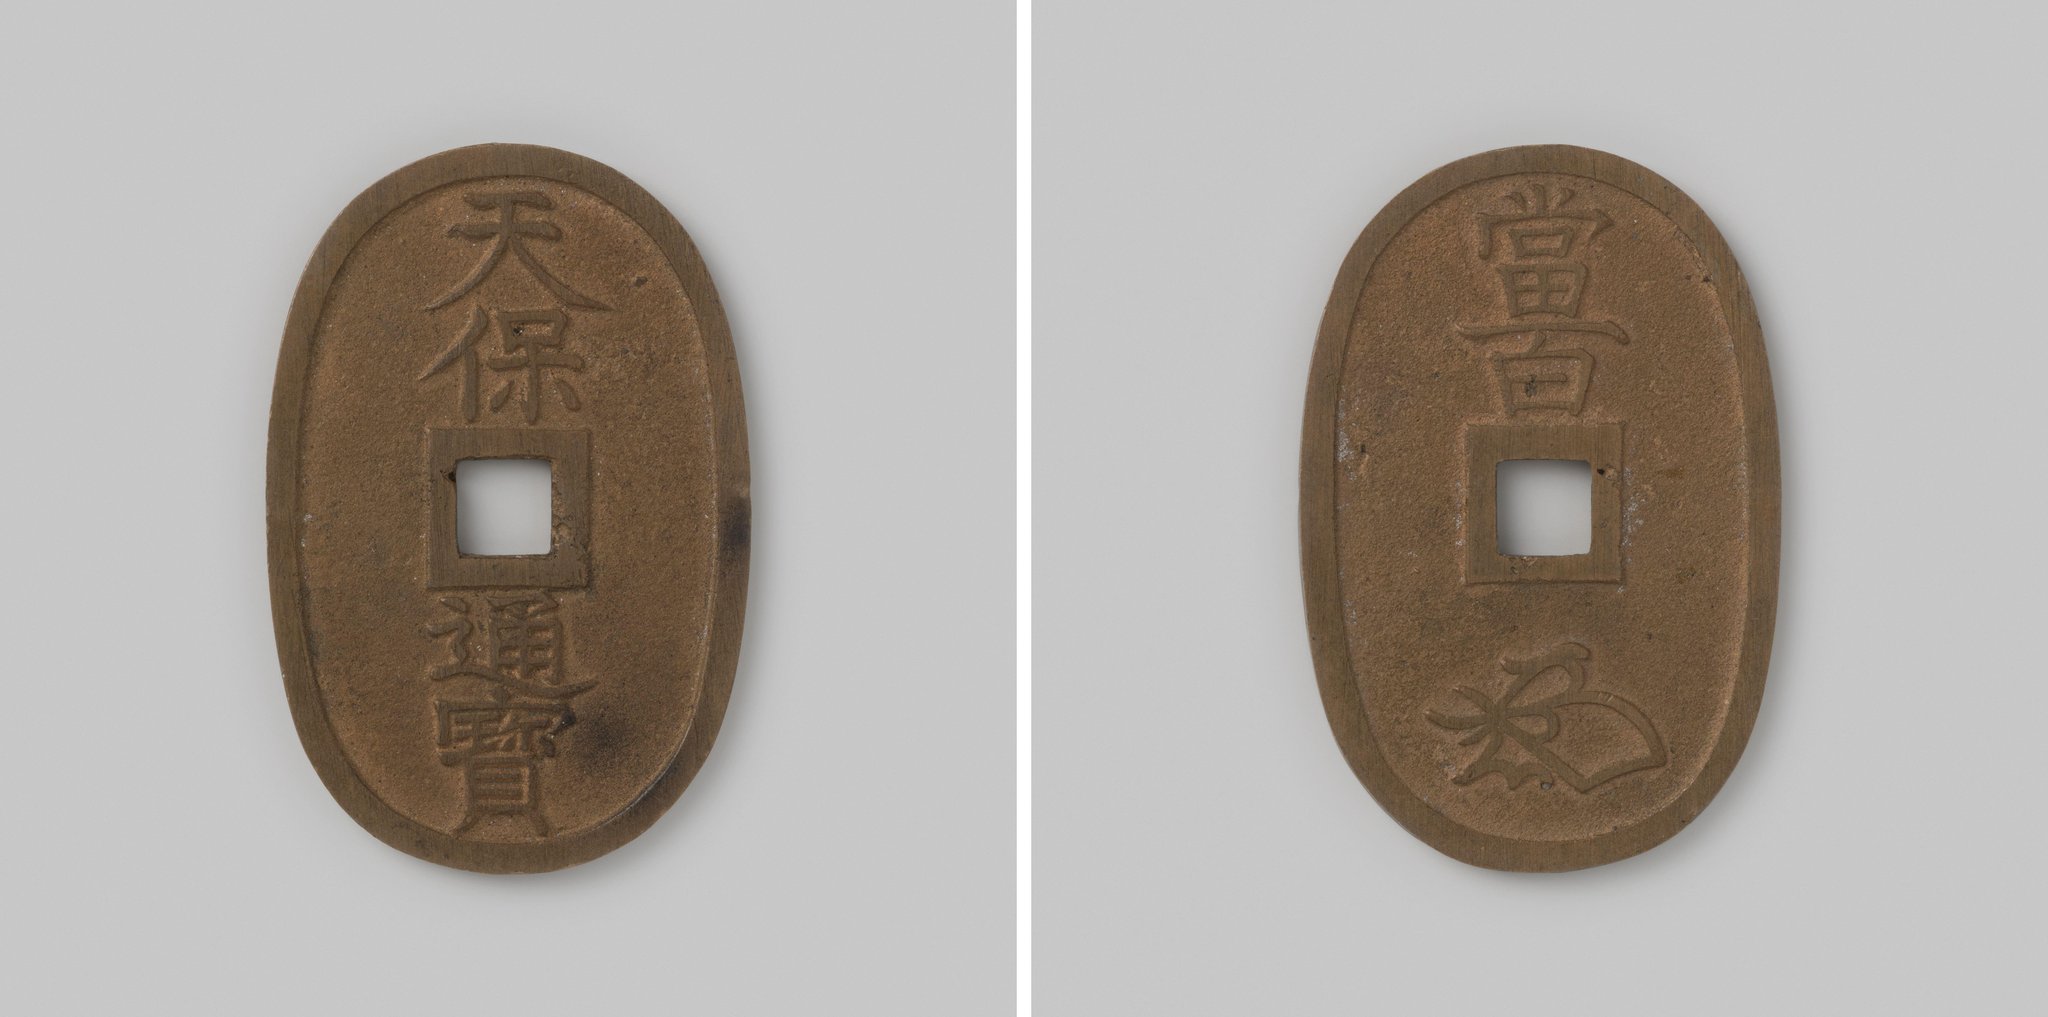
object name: coin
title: Sen van 100 mon van het keizerrijk Japan, uit het Tenpo tijdperk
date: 1830-1843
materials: copper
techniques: casting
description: Koperen langwerpige, ovale munt. Voorzijde: in het midden vierkante uitsparing, waarboven twee tekens, tezamen het Tenpo tijdperk aanduidend en waaronder ook twee tekens. Keerzijde: in het midden vierkante uitsparing, waarboven twee tekns en waaronder een teken, tezamen vormend de waarde-aanduiding: 100 mon.